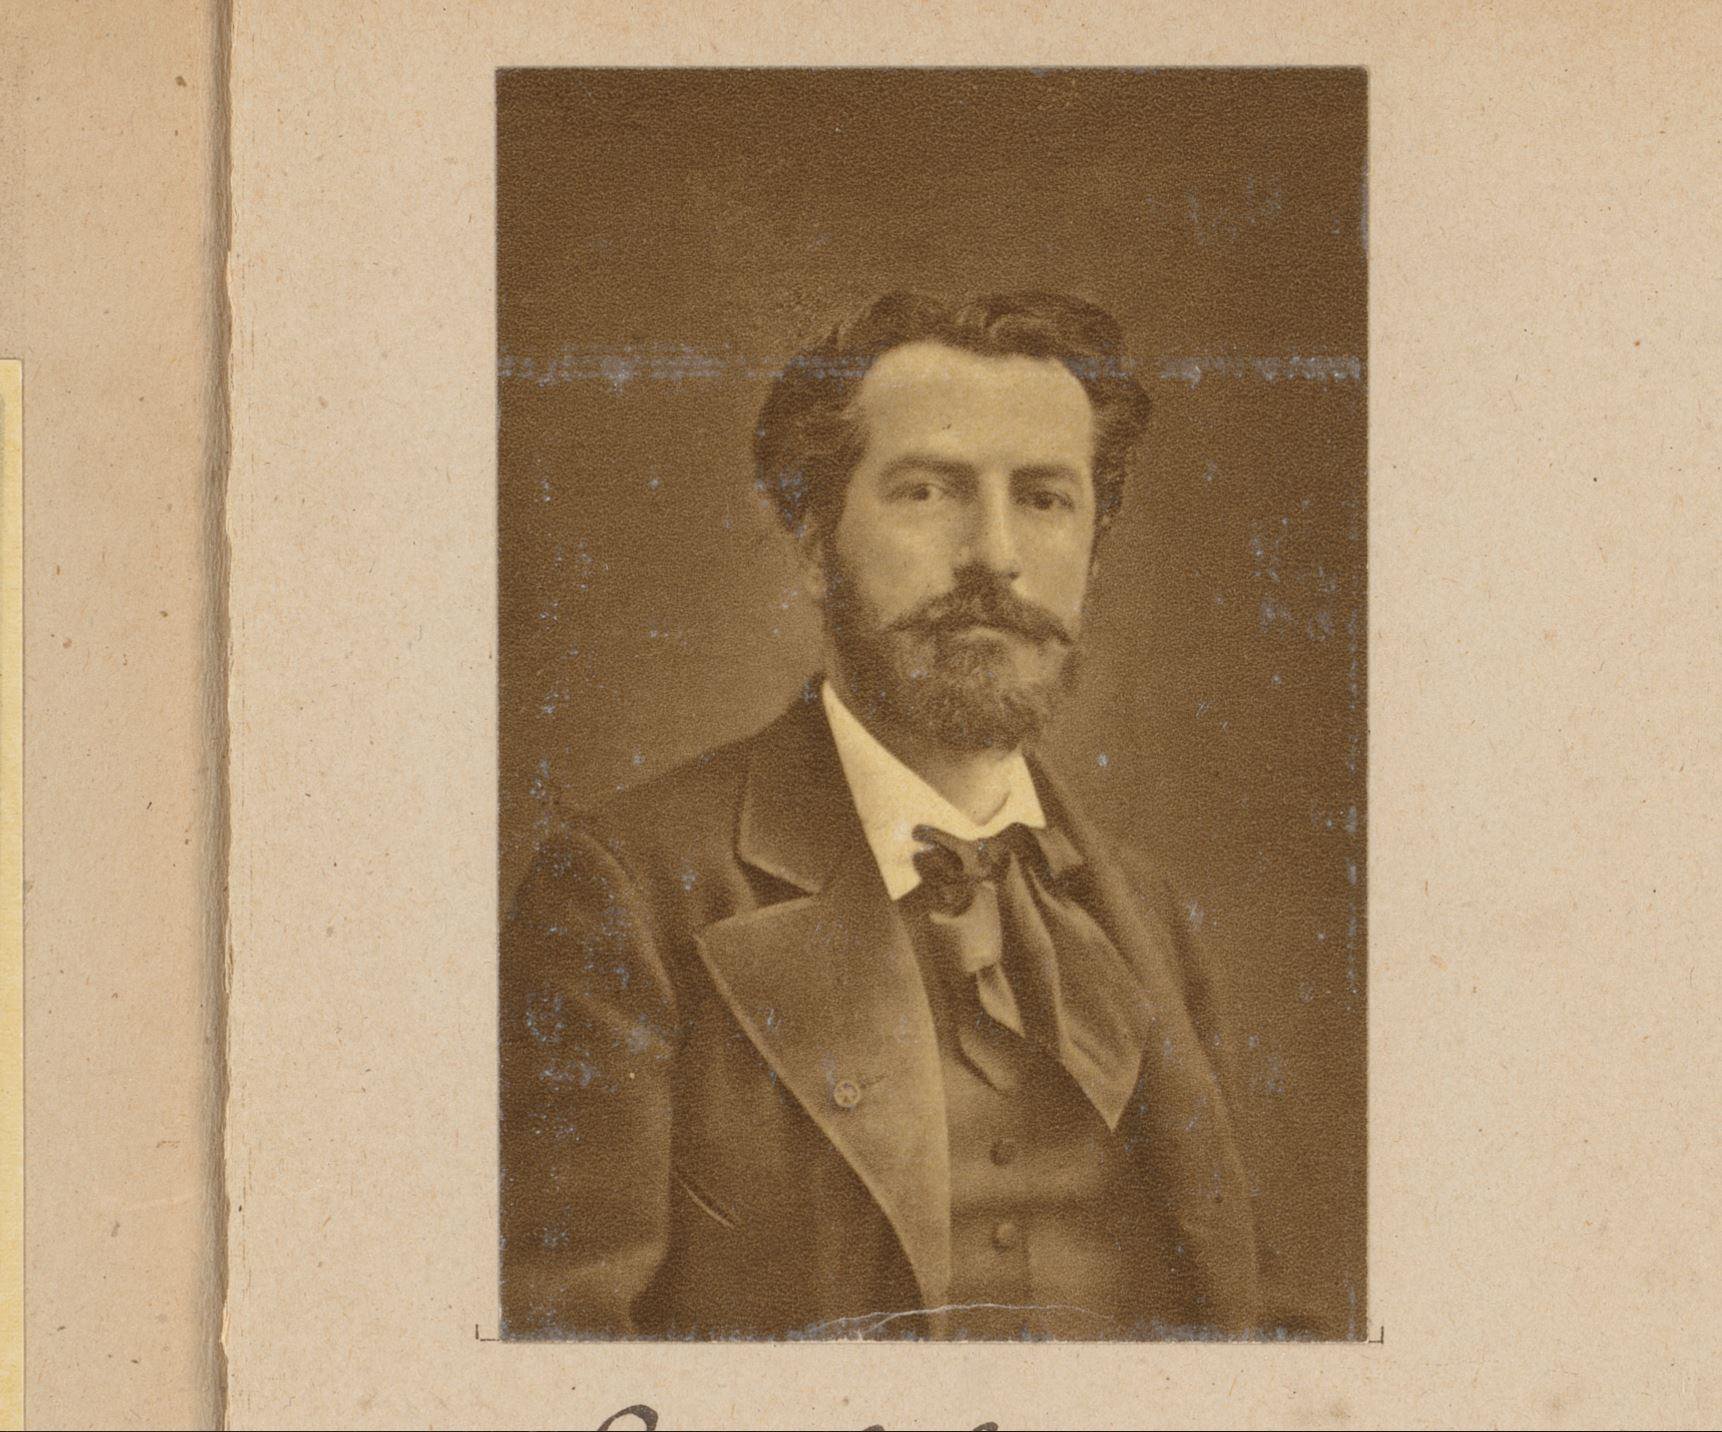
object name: photograph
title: Bartholdi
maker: Anonymous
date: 1880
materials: paper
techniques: rotogravure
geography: france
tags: paris, sculptor, frédéric auguste bartholdi, historical persons, artist (in general), france